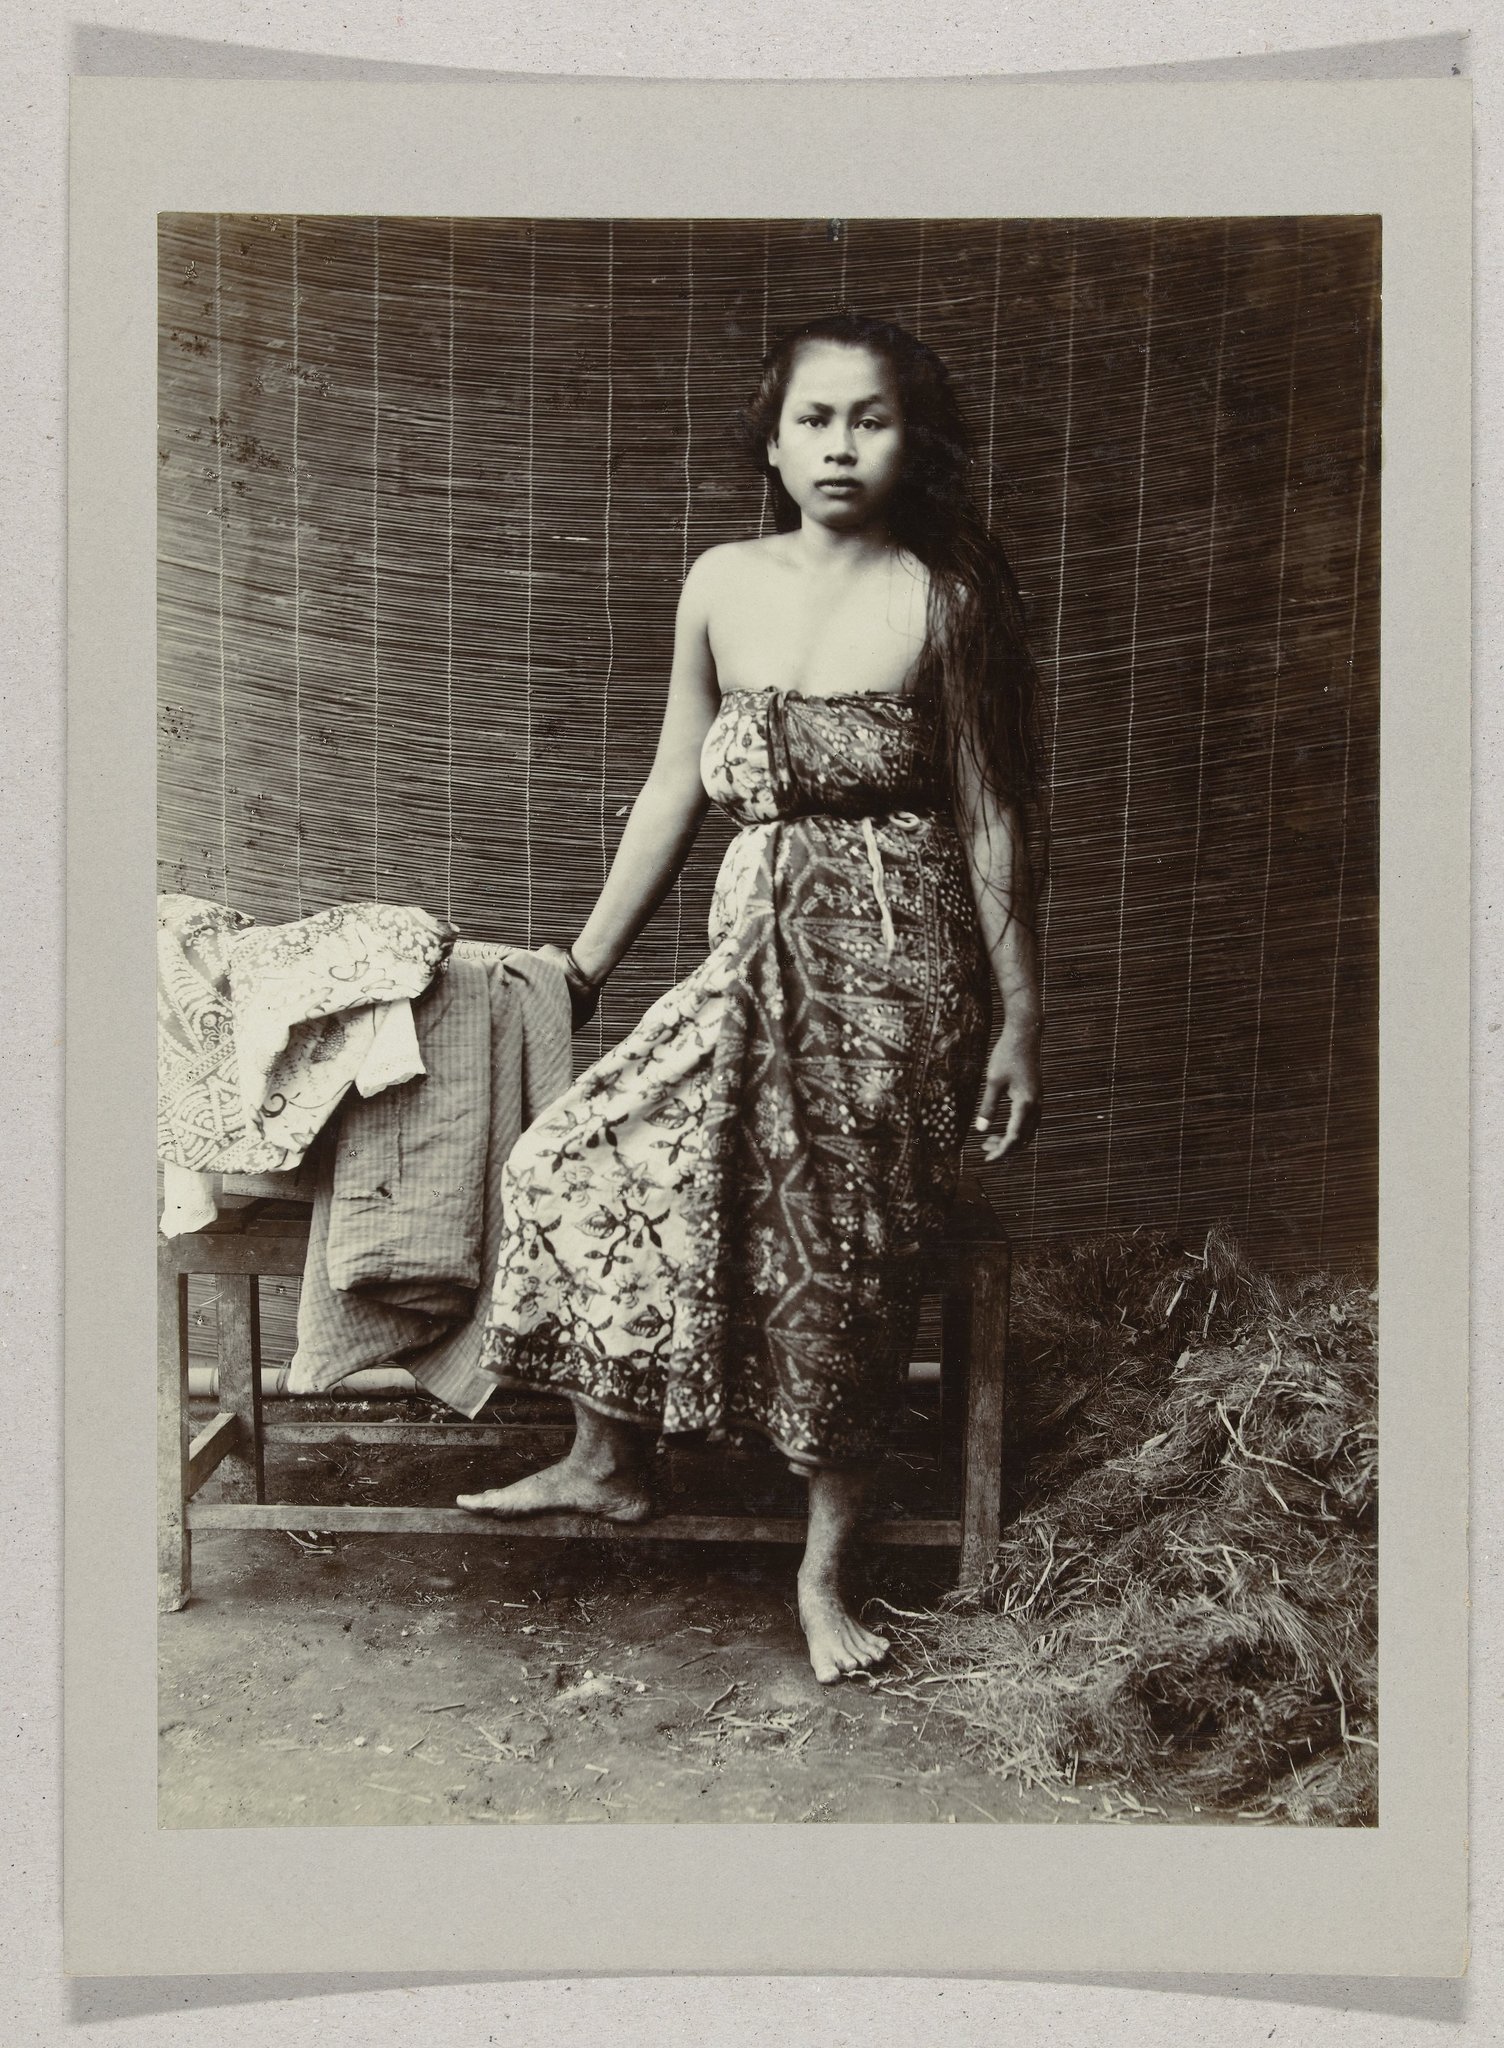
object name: photograph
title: Studioportret van een meisje in Nederlands-Indië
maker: Anonymous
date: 1895-1915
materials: cardboard, paper, photographic support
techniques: gelatin silver print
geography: dutch east indies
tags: indonesia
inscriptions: number: ‘30’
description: Portret van een meisje, gemaakt in een studio (?), Nederlands-Indië